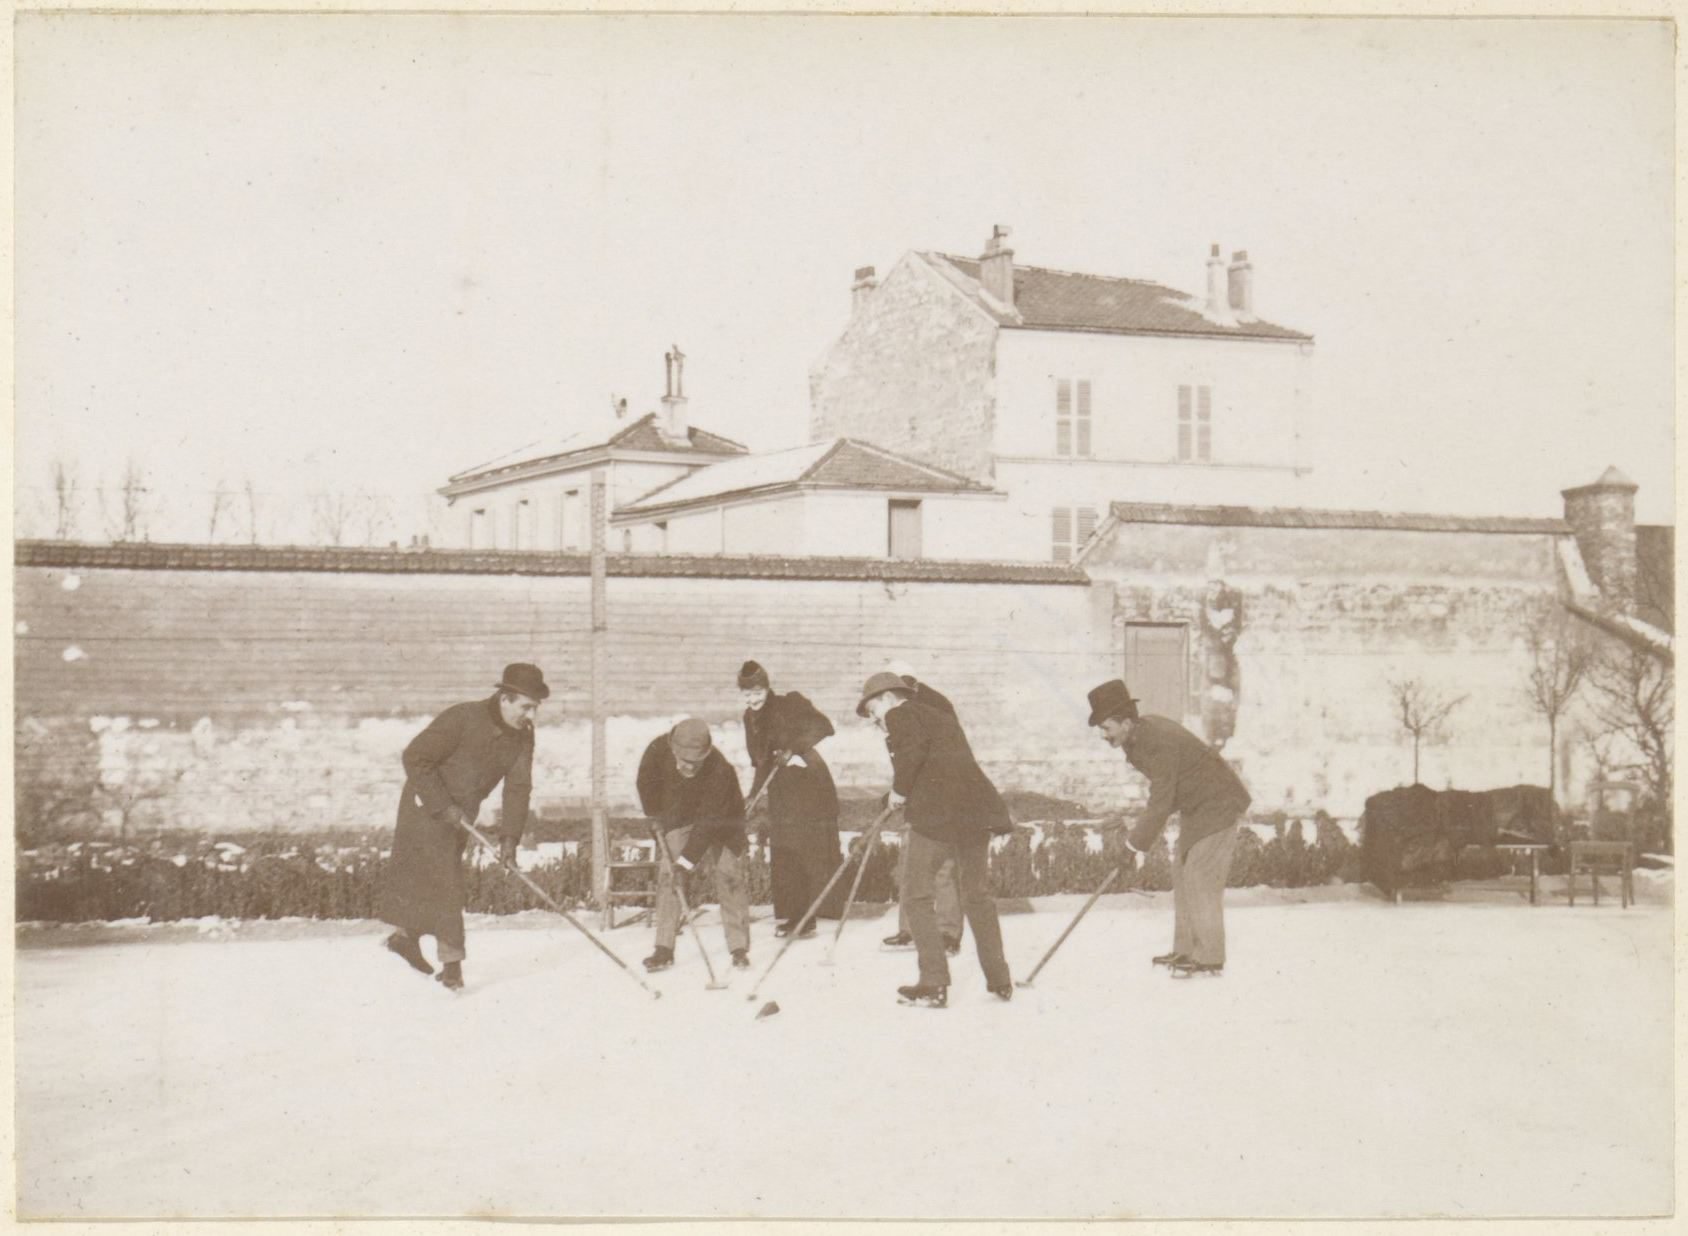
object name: photograph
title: IJshockeyspelend gezelschap, vermoedelijk in Frankrijk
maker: Anonymous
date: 1900-1910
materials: paper, photographic support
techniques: daylight paper print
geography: france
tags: ice hockey, skates (winter sports), france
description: Onderdeel van Fotoalbum van een Franse amateurfotograaf met opnames van een familie, distilleerderij Delizy & Doistau Fils, het leger en bezienswaardigheden in Frankrijk.